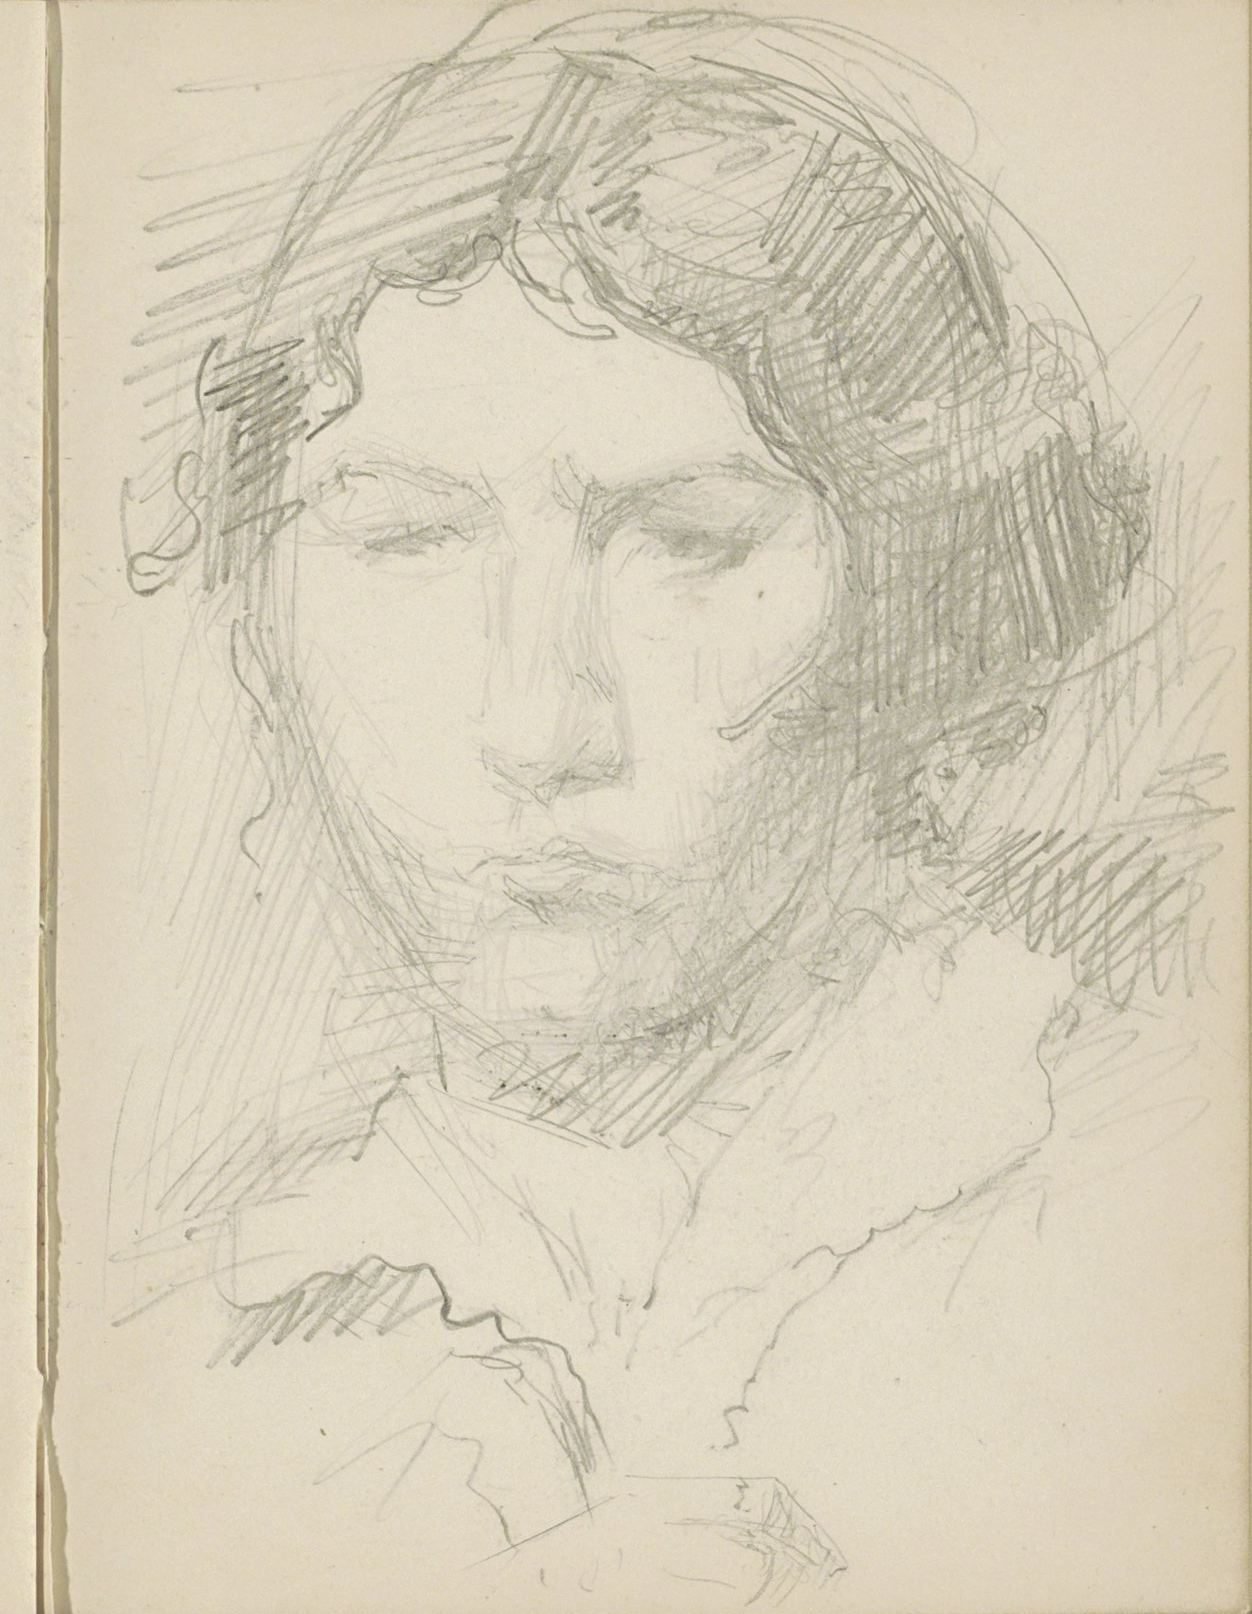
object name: sketchbook leaf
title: Portret van een vrouw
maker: reijer stolk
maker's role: draughtsman, print maker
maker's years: 1896-1945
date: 1906-1945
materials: paper, pencil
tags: head (human) - aa - female human figure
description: Blad 29 recto uit een schetsboek met 69 bladen.